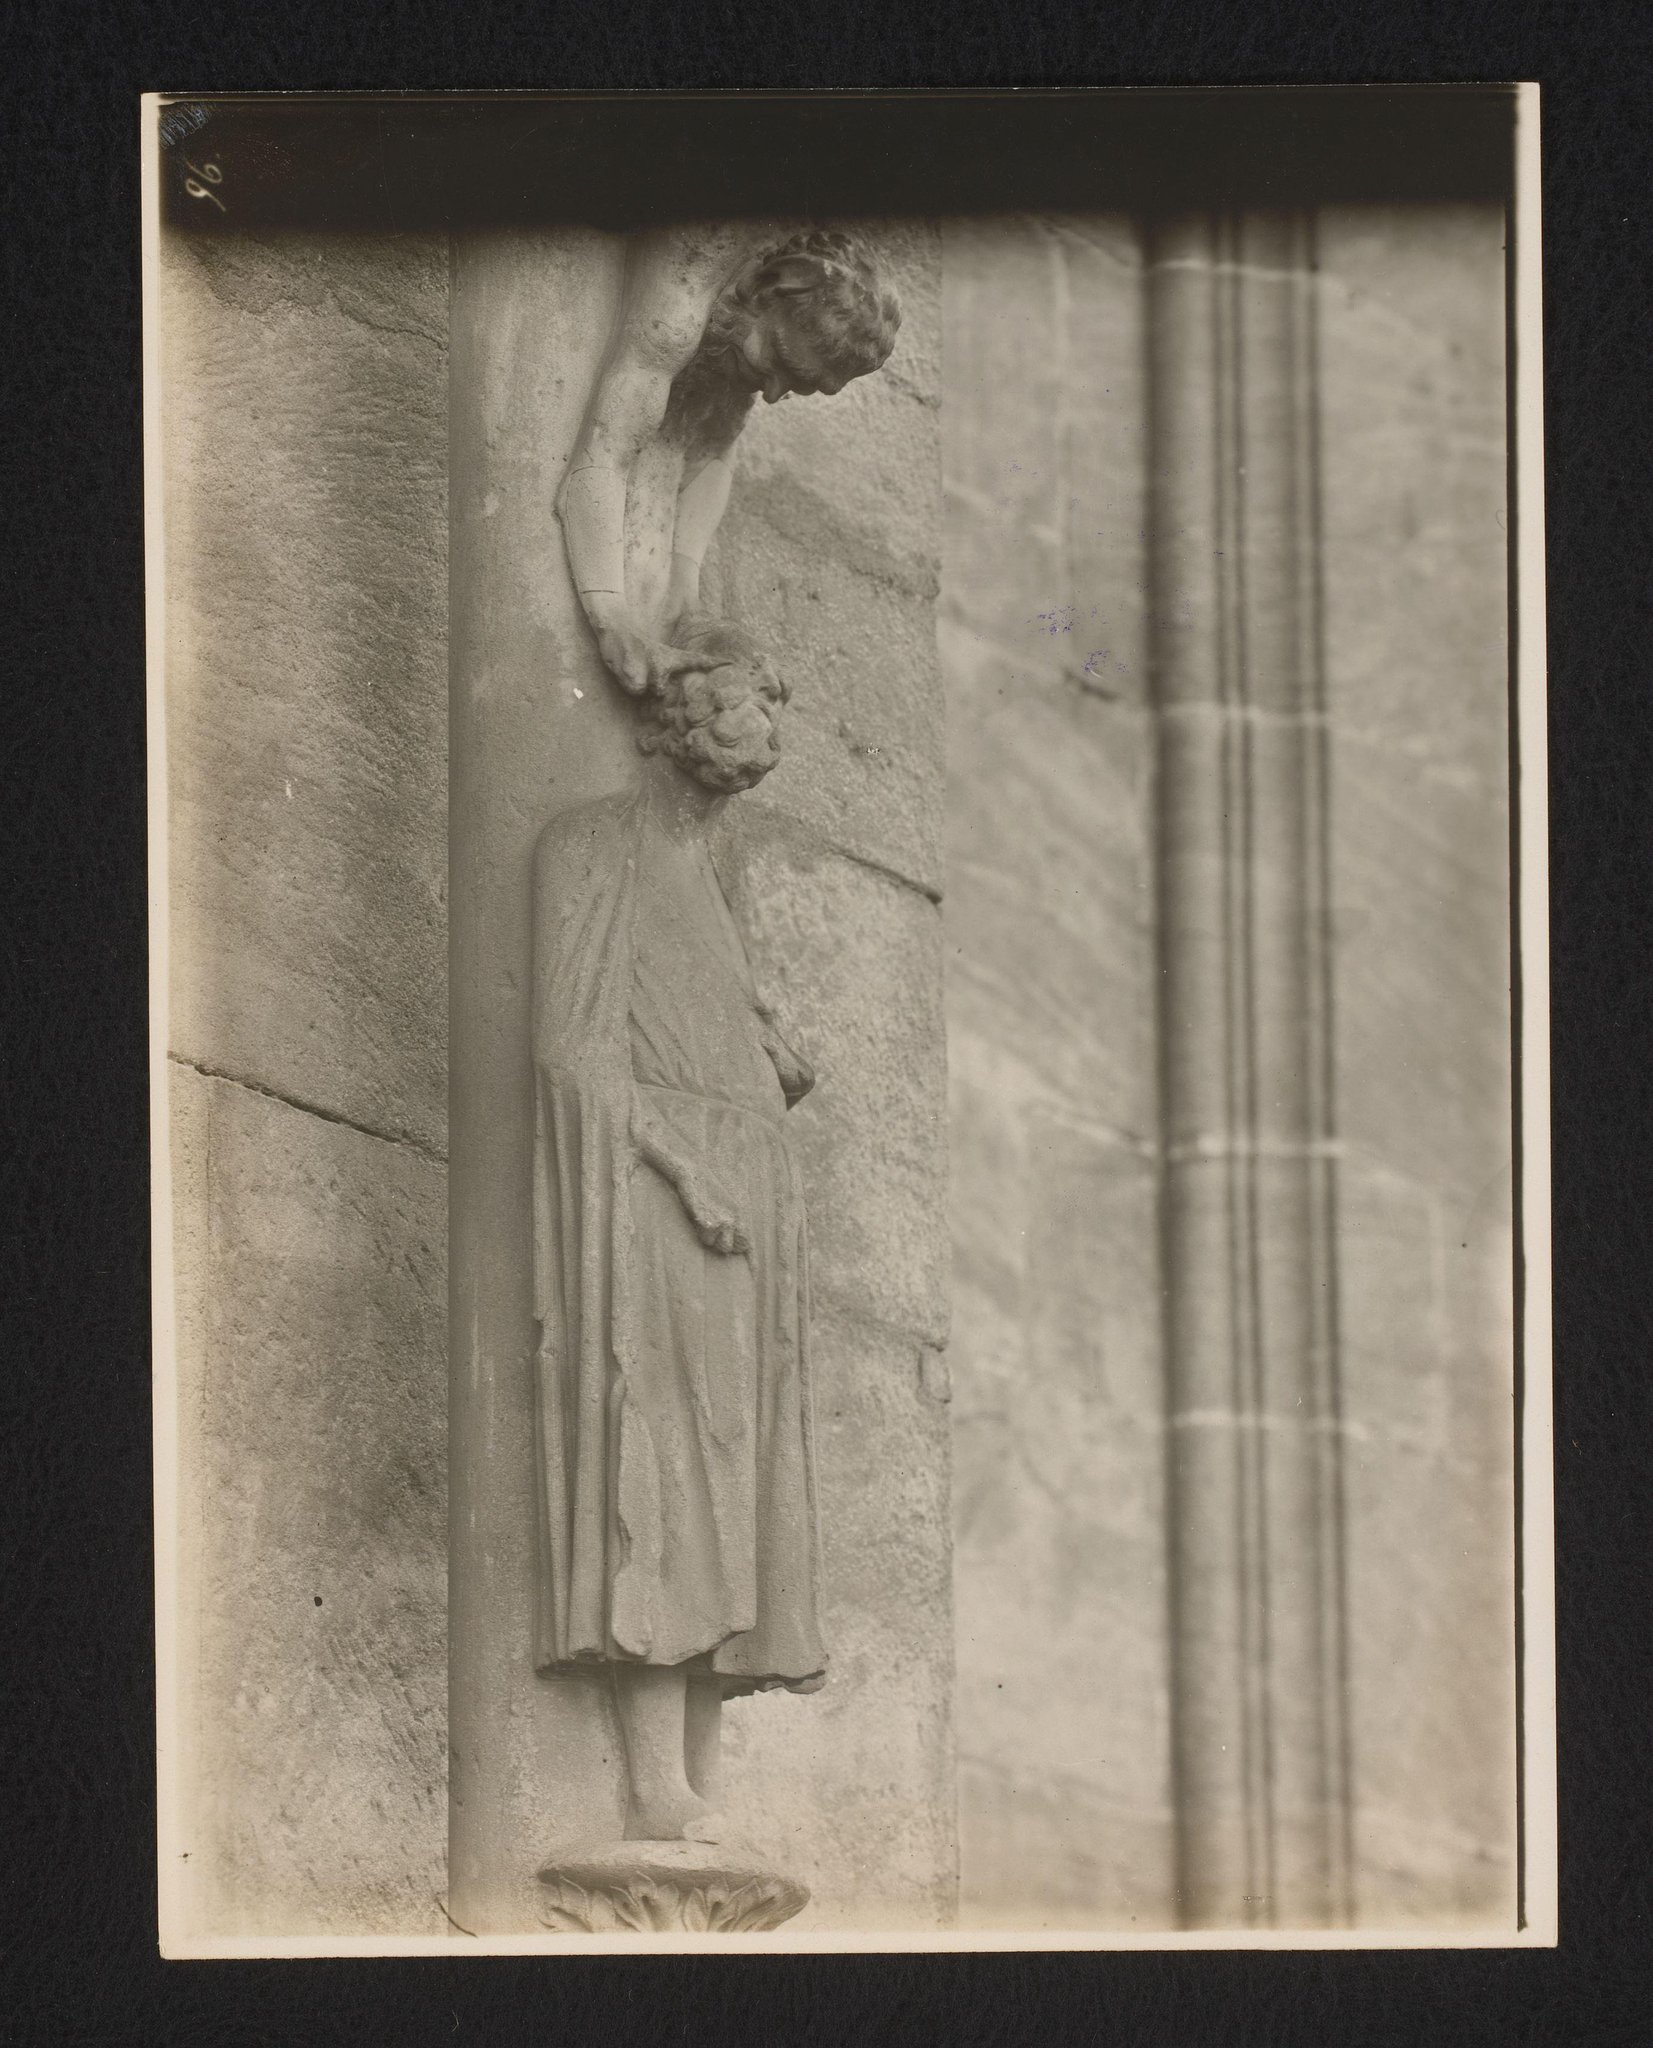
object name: photograph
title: Detail van het Fürstenportal in de dom van Bamberg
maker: Anonymous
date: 1900-1920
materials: paper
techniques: gelatin silver print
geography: bamberg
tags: church (exterior)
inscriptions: inscription: ‘Kunsthist. Seminar/ Marburg (Lahn)/ Photogr. Abteilung/ Vervielfältigung/ untersagt.’, number: ‘96’